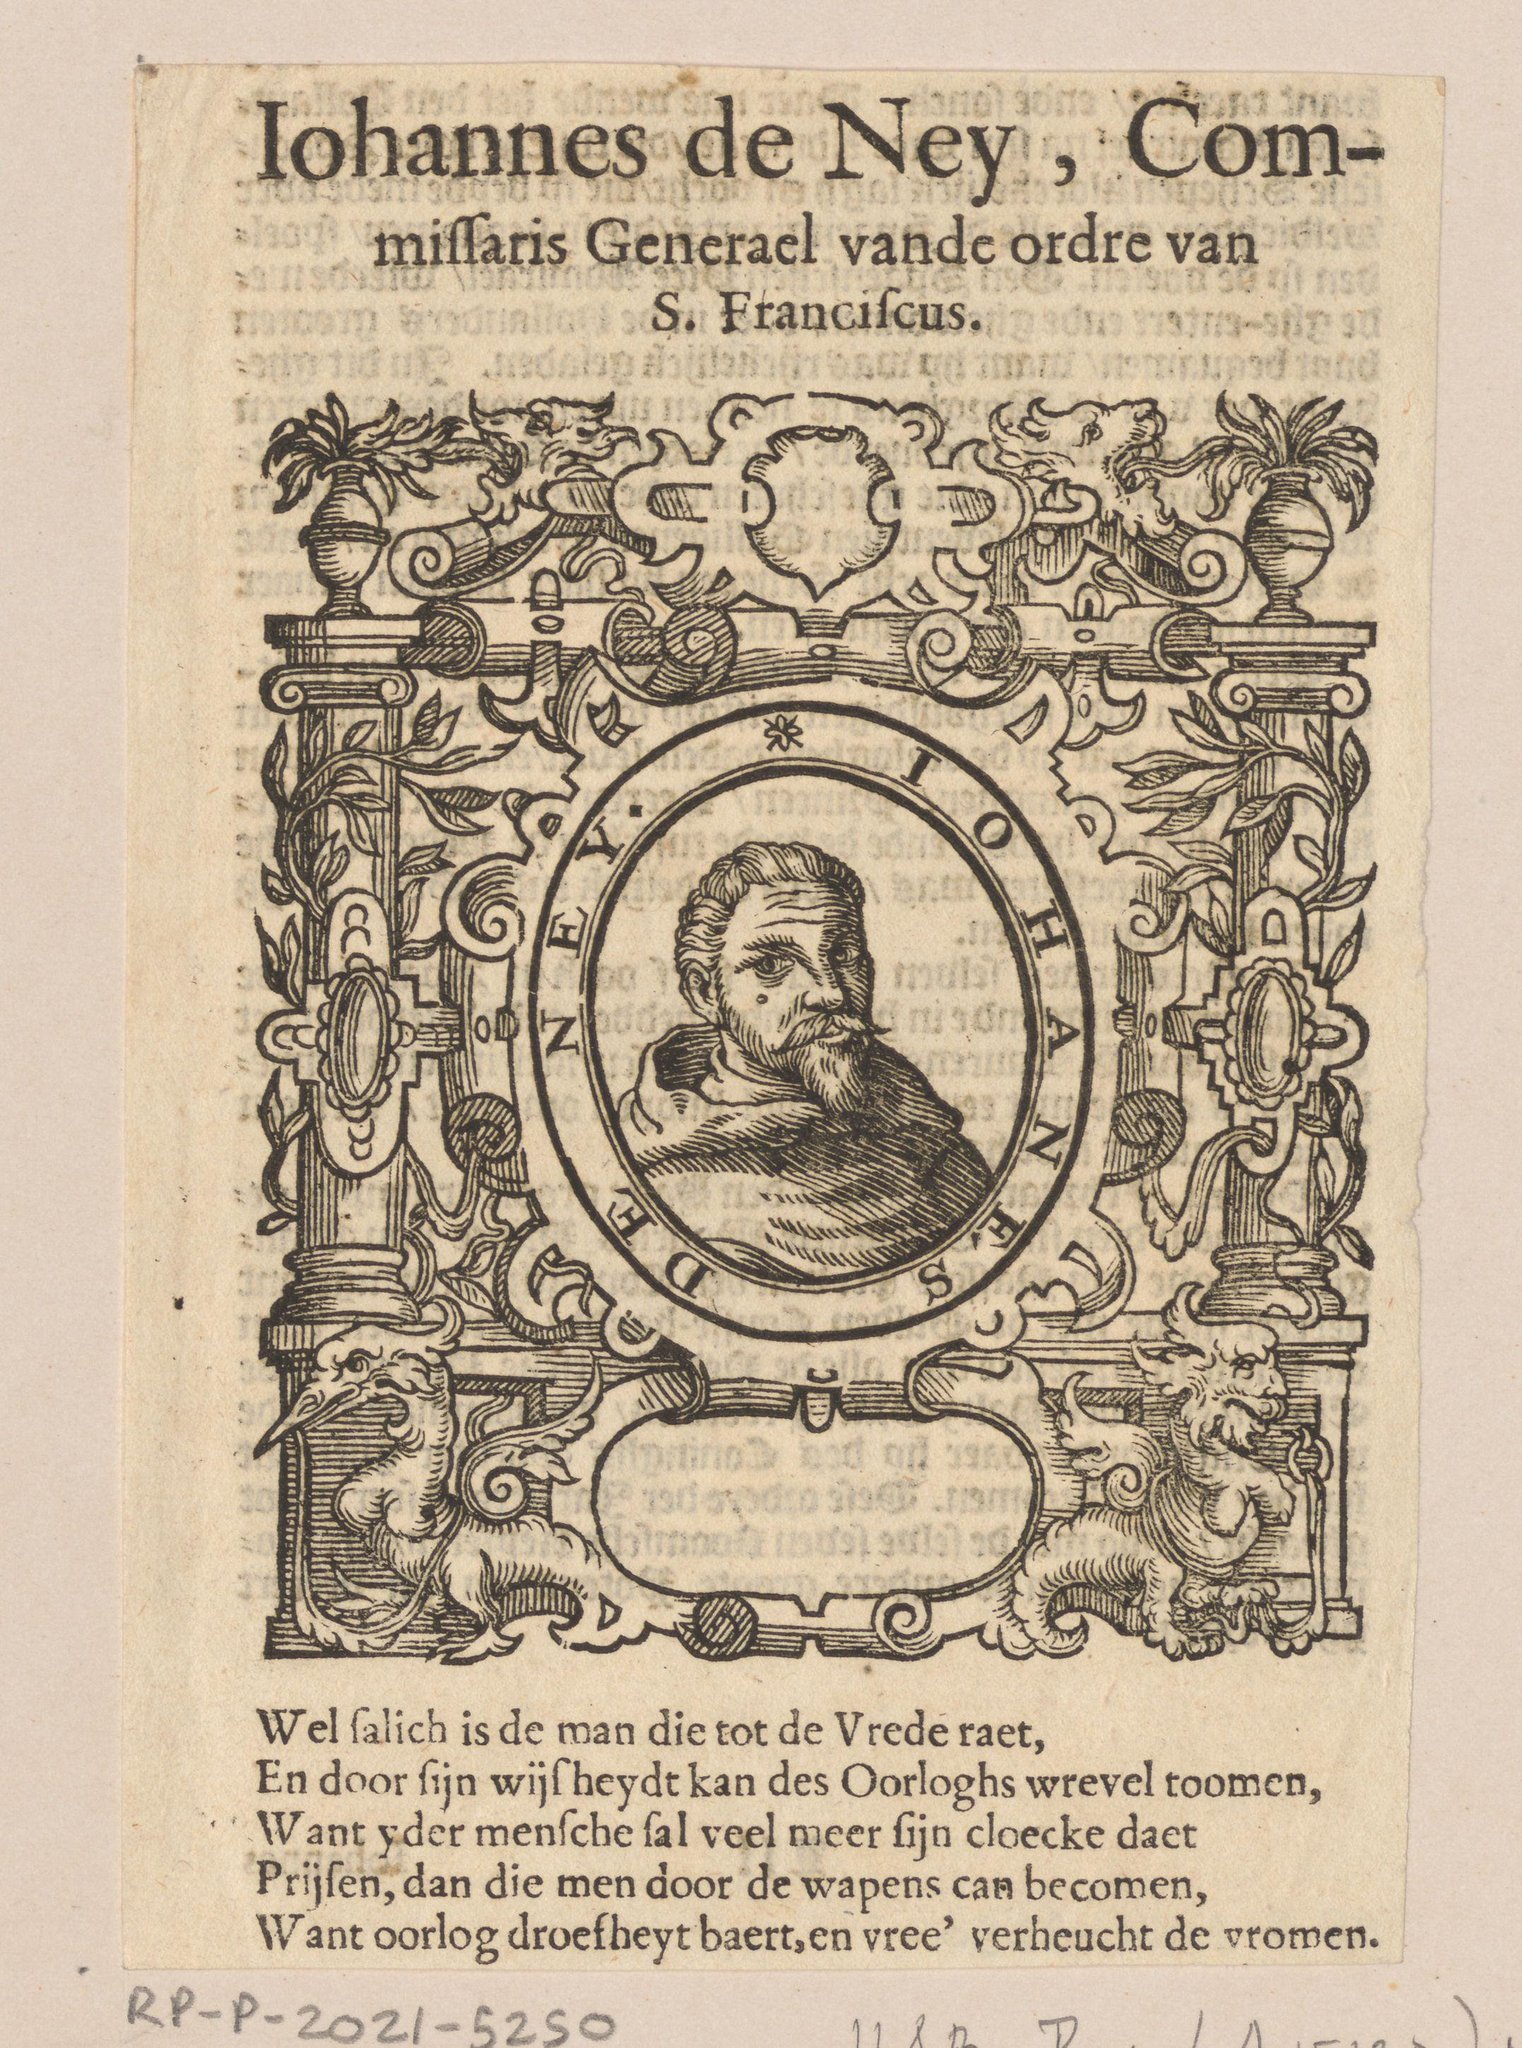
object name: book illustration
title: Portret van Jan Neyen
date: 1636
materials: paper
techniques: letterpress printing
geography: amsterdam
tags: antwerp, spain, historical persons, diplomacy, diplomat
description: Prent uit: Scriverius, Petrus. Beschrivinge van Out Batavien(...). Amsterdam: Jan Evertsz Cloppenburgh II, 1636. Prent met andere omlijsting gebruikt in de editie van 1646.